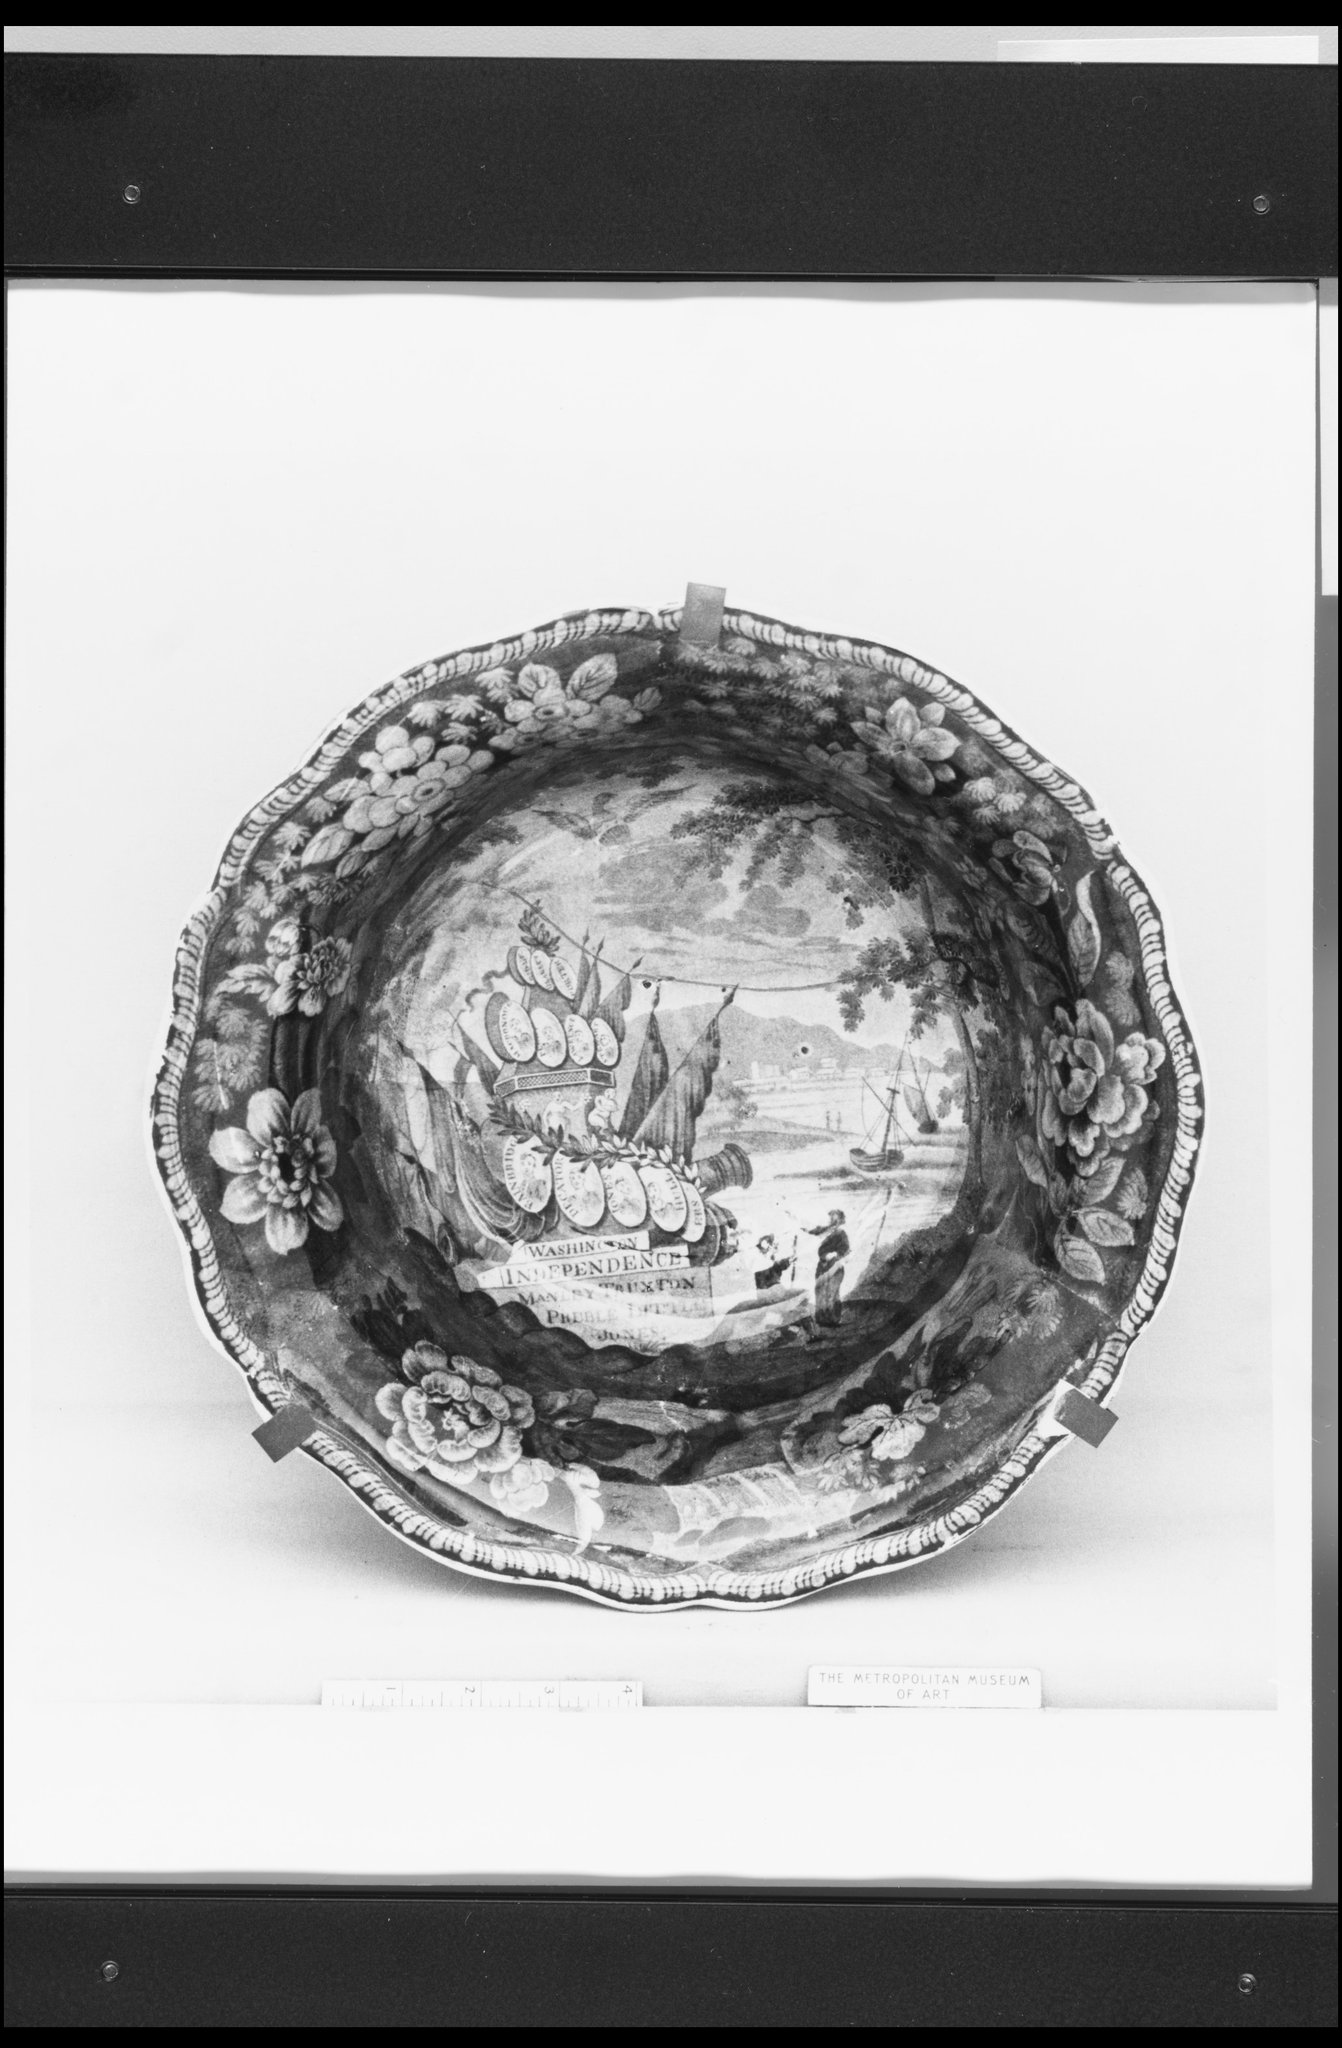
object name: plate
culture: british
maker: ralph stevenson & williams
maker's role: maker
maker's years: 1822-1827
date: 1825-1827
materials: earthenware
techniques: transfer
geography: england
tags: cannons,flowers